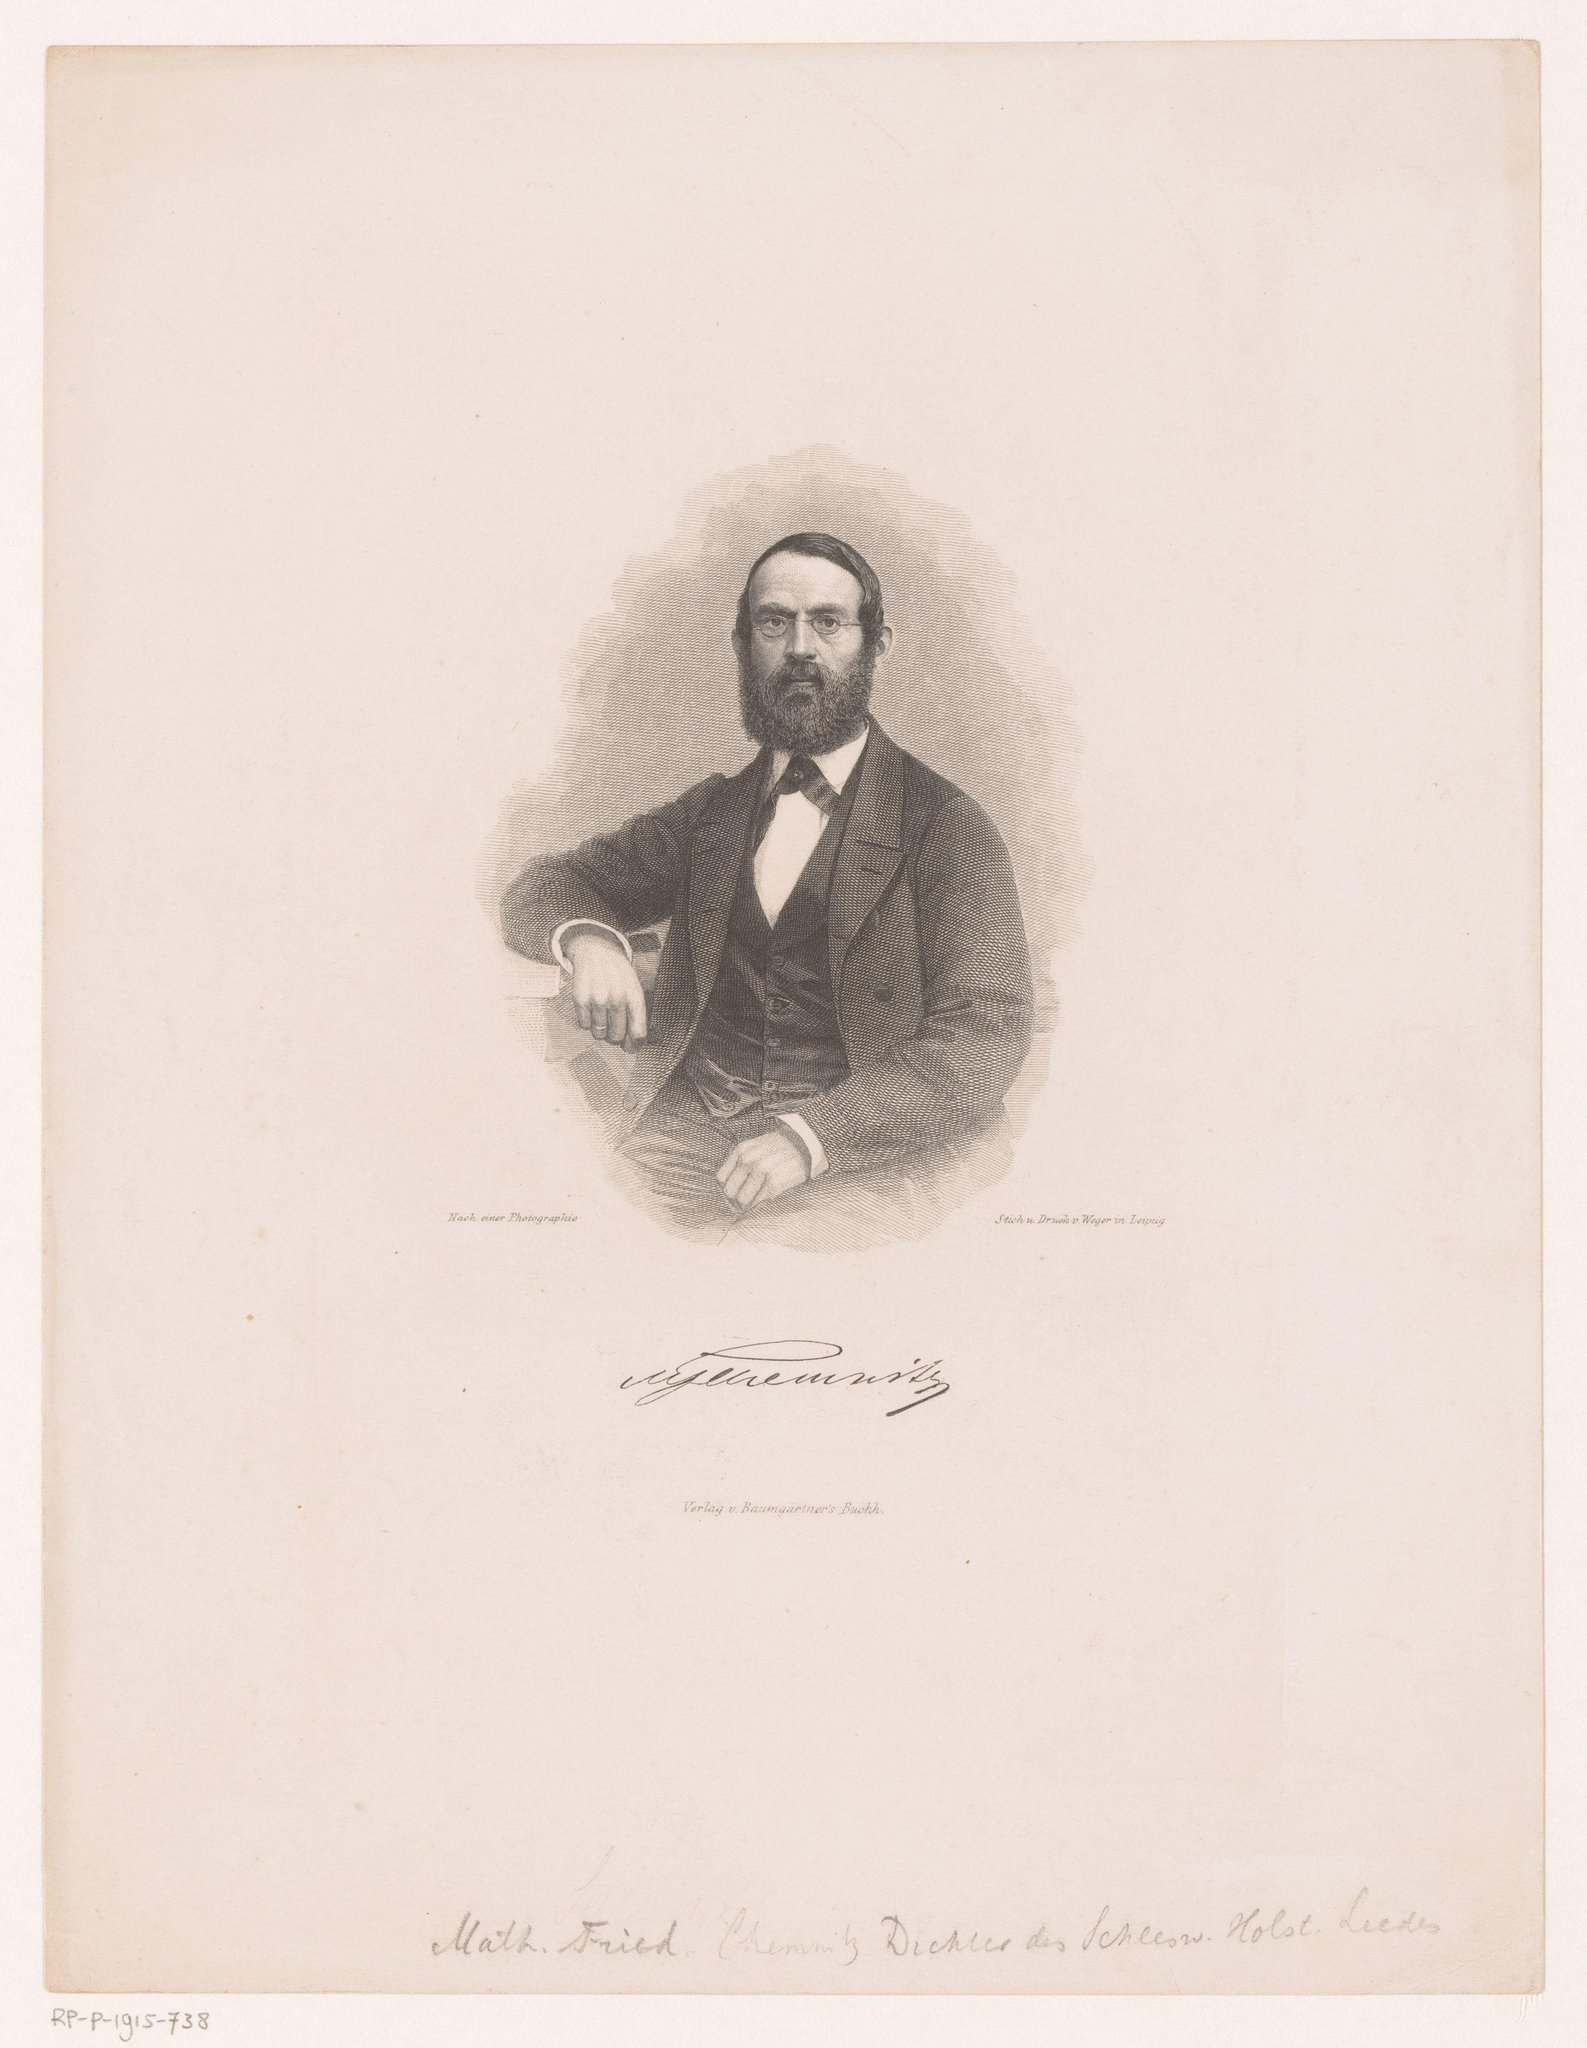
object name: print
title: Portret van Matthäus Friedrich Chemnitz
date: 1849-1892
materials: paper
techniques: engraving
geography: leipzig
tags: historical persons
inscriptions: collector's mark: Lugt 2228